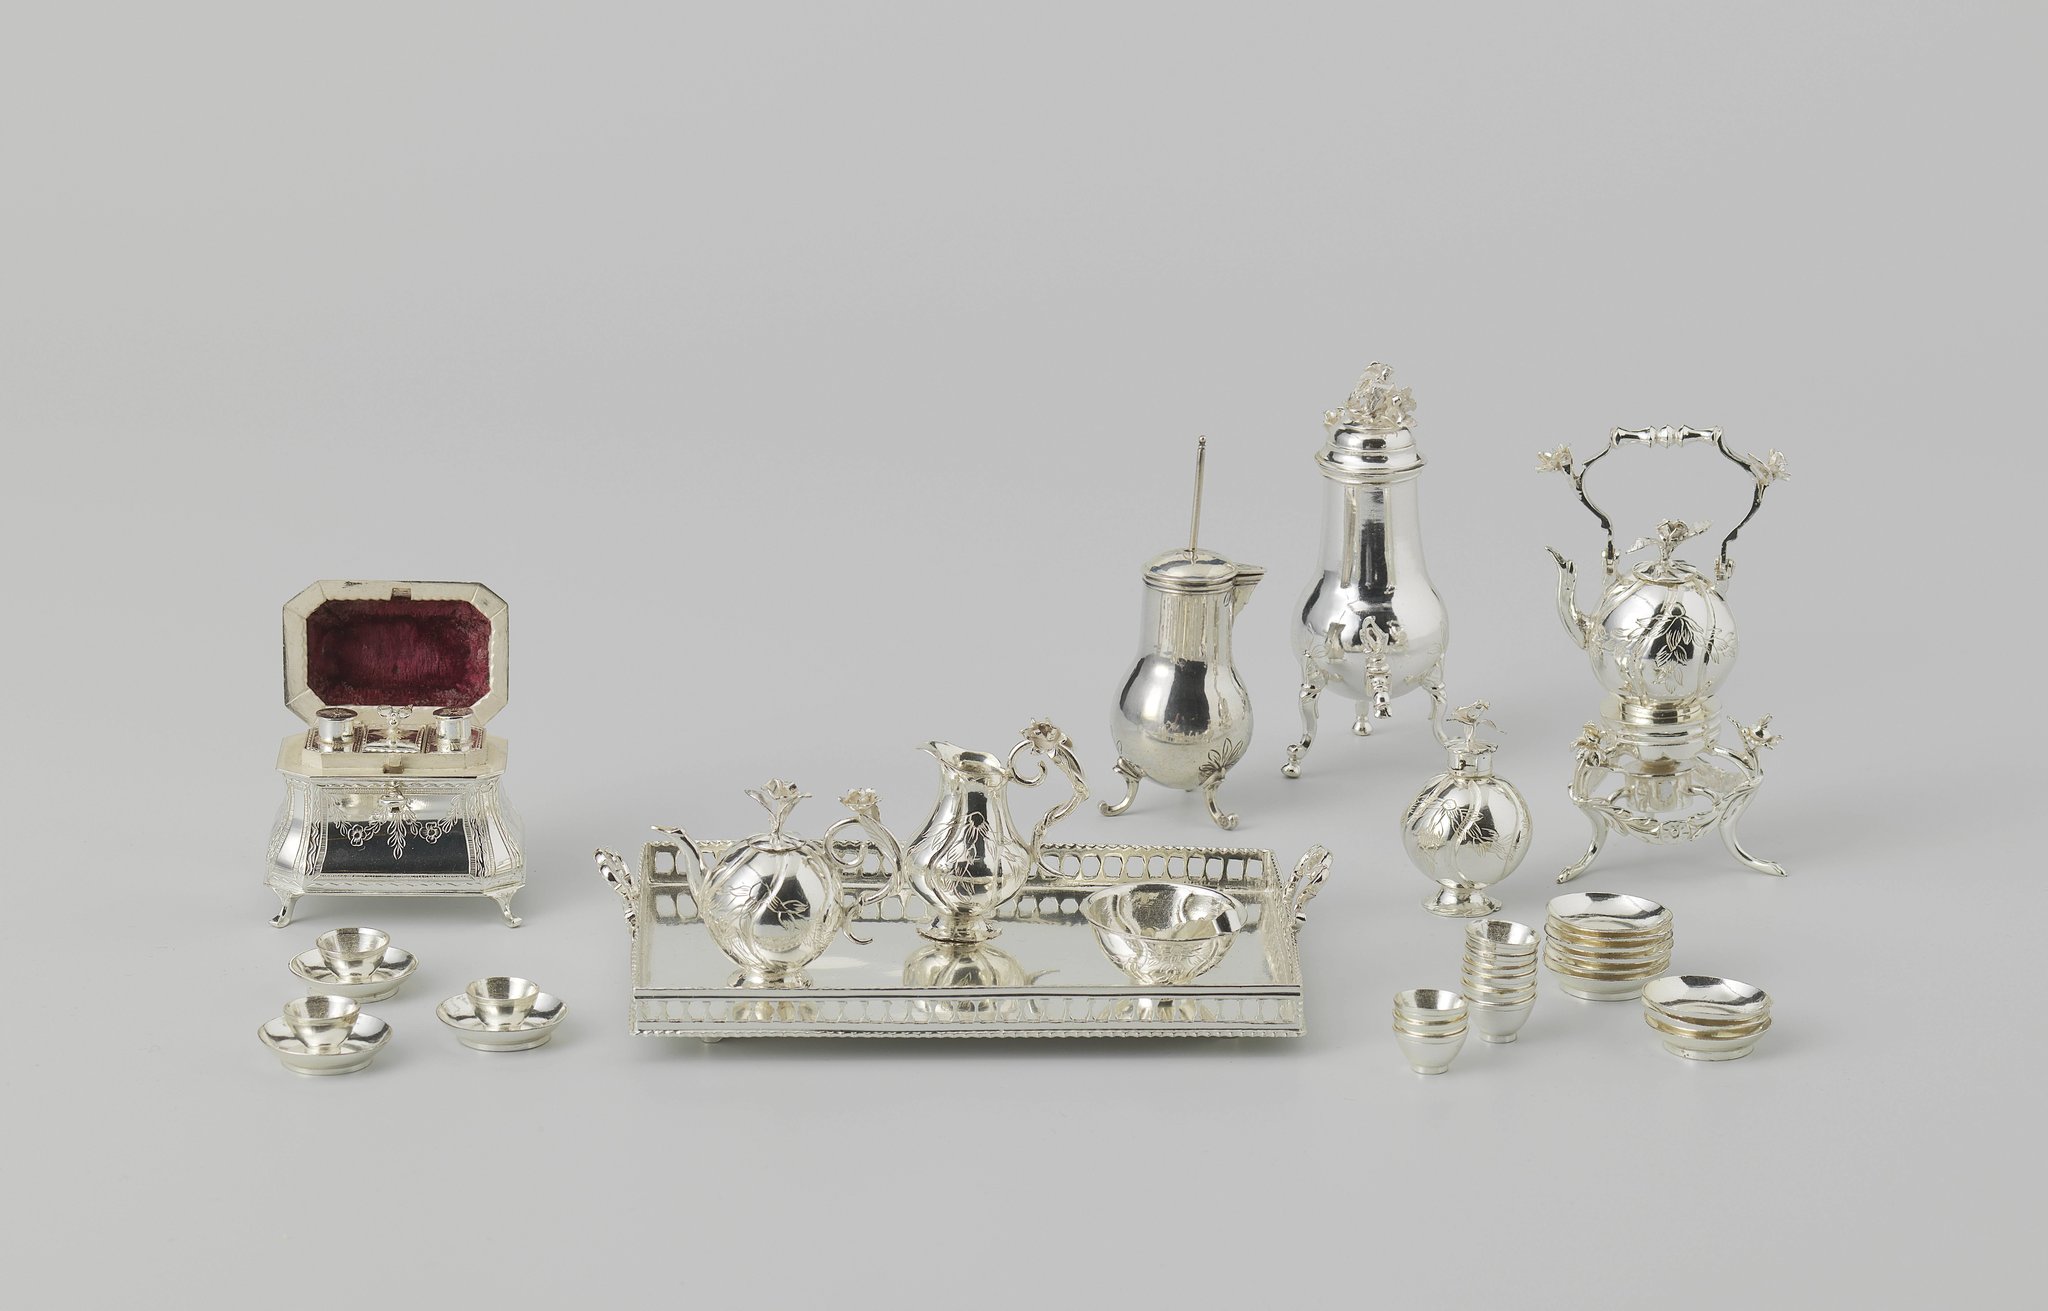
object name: miniature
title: Theeservies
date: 1775-1811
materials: silver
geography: amsterdam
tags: tea- and coffee-service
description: Theeservies op rechthoekig blad, bestaande uit: theepot (BK-NM-11177-142-a), theebus (BK-NM-11177-142-b), kop en schotel (BK-NM-11177-142-c t/m BK-NM-11177-142-h en BK-NM-11177-142-j t/m BK-NM-11177-142-o), melkkan (BK-NM-11177-142-i), suikerkom (BK-NM-11177-142-p) en een suikertang (BK-NM-11177-142-q). Het invnr. van het blad is: BK-NM-11177-142-r.